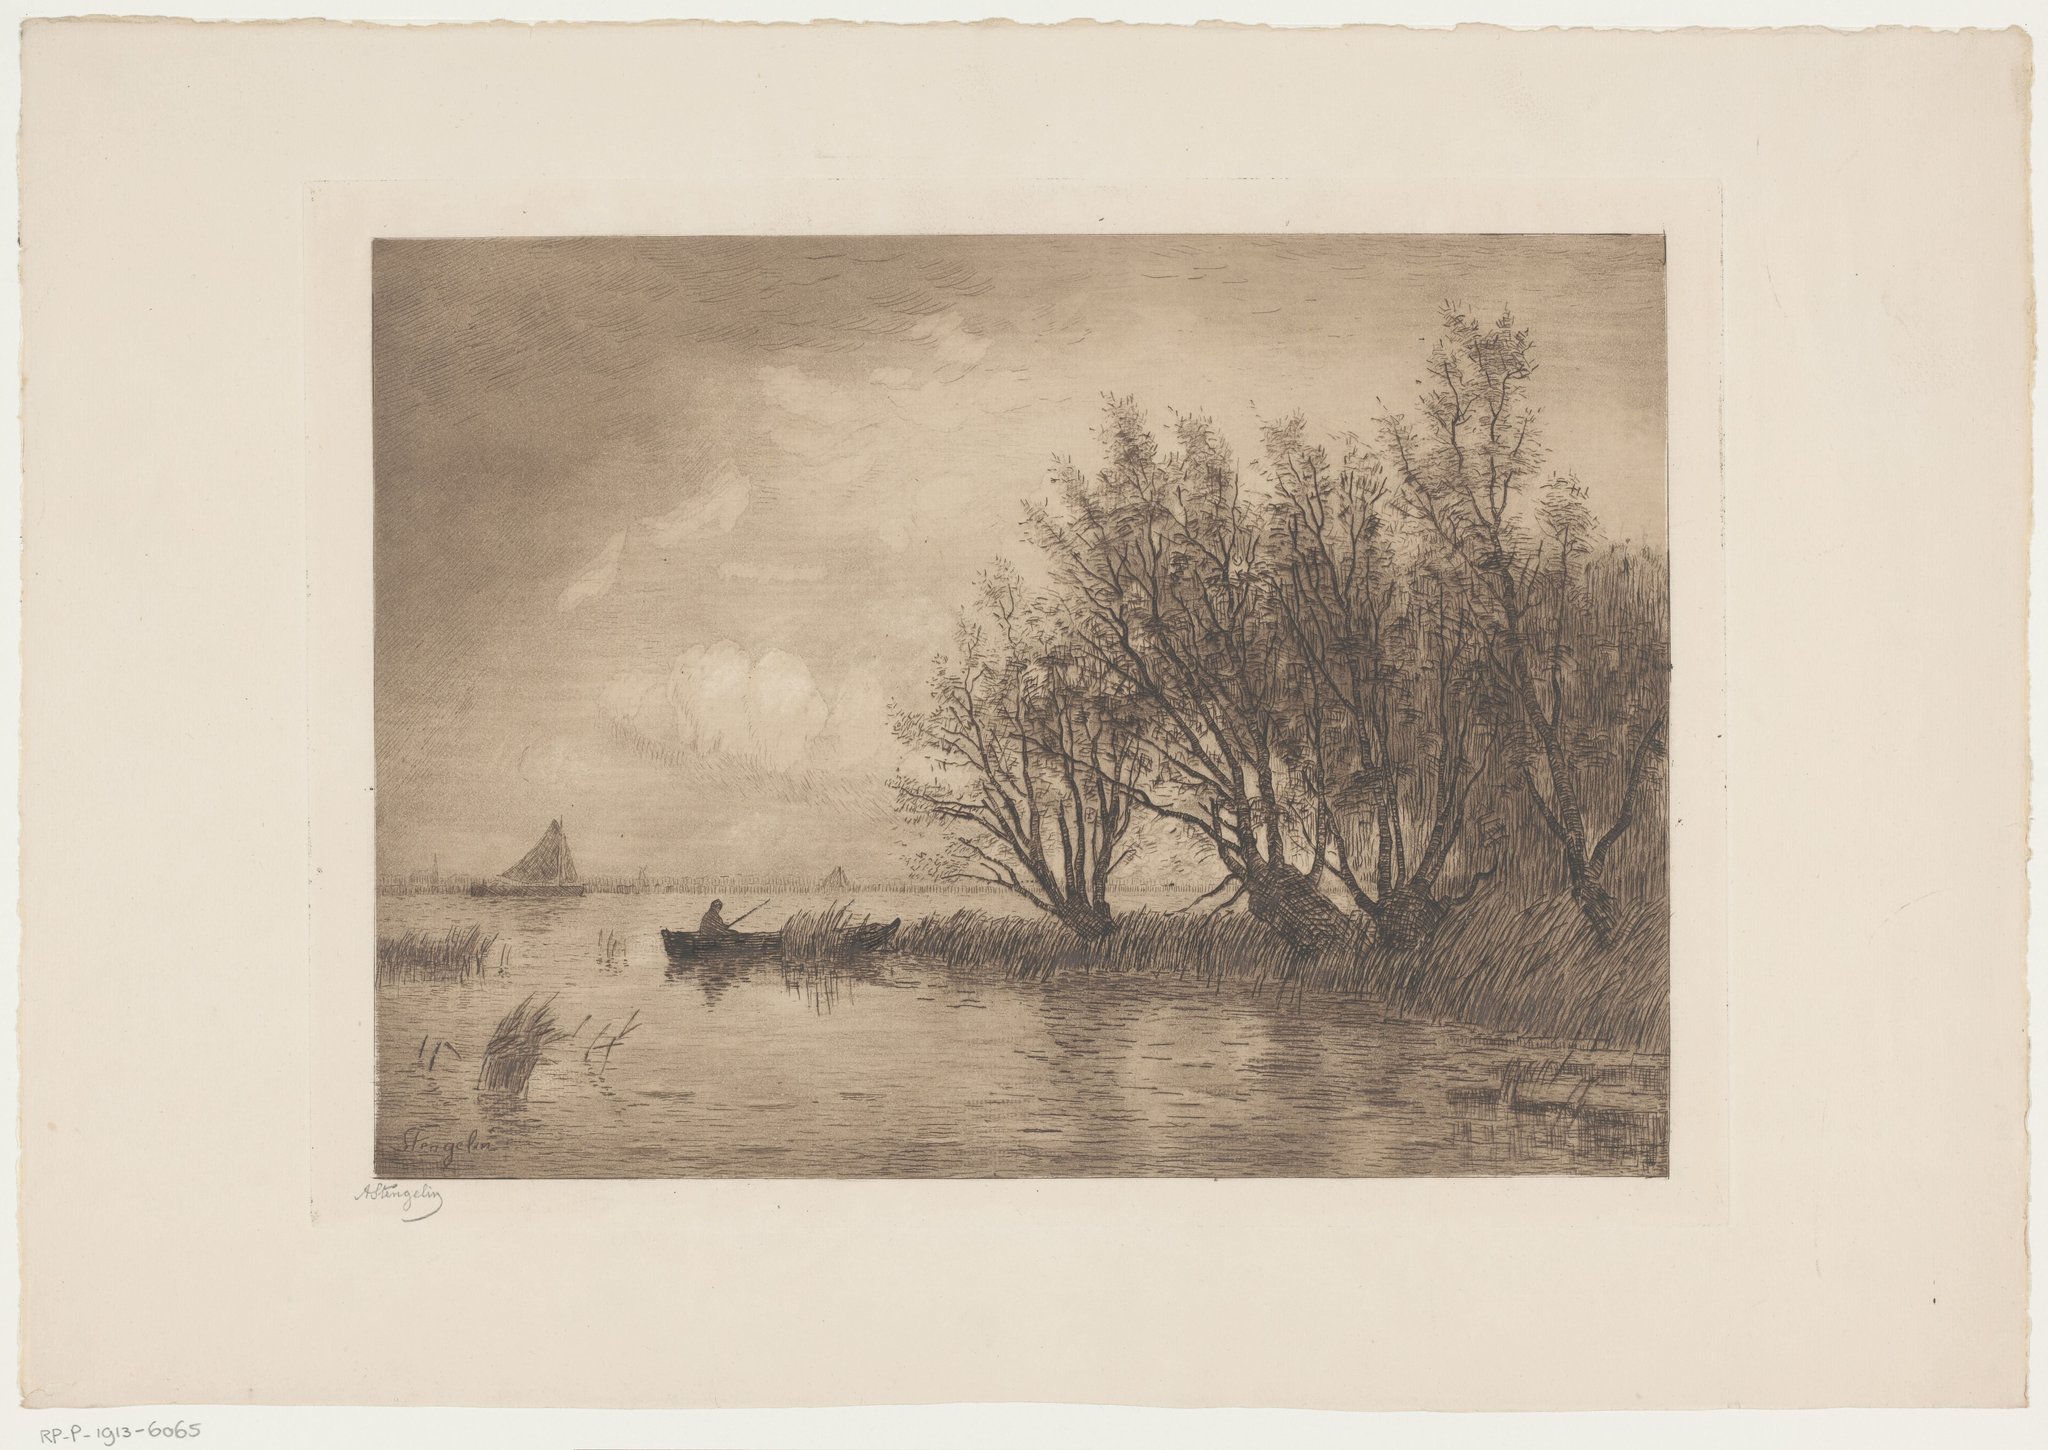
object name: print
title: Rivierlandschap met roeiboot en bomen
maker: alphonse stengelin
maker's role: painter, print maker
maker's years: 1852-1938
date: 1862-1913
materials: paper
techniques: aquatint, etching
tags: landscapes with waters, waterscapes, seascapes (in the temperate zone), rowing-boat, canoe, etc.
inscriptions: collector's mark: Lugt 2233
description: Uitzicht over het water met een visser in een roeiboot, met rechts de oever met grote bomen. Aan de horizon een kerktoren en een molen.